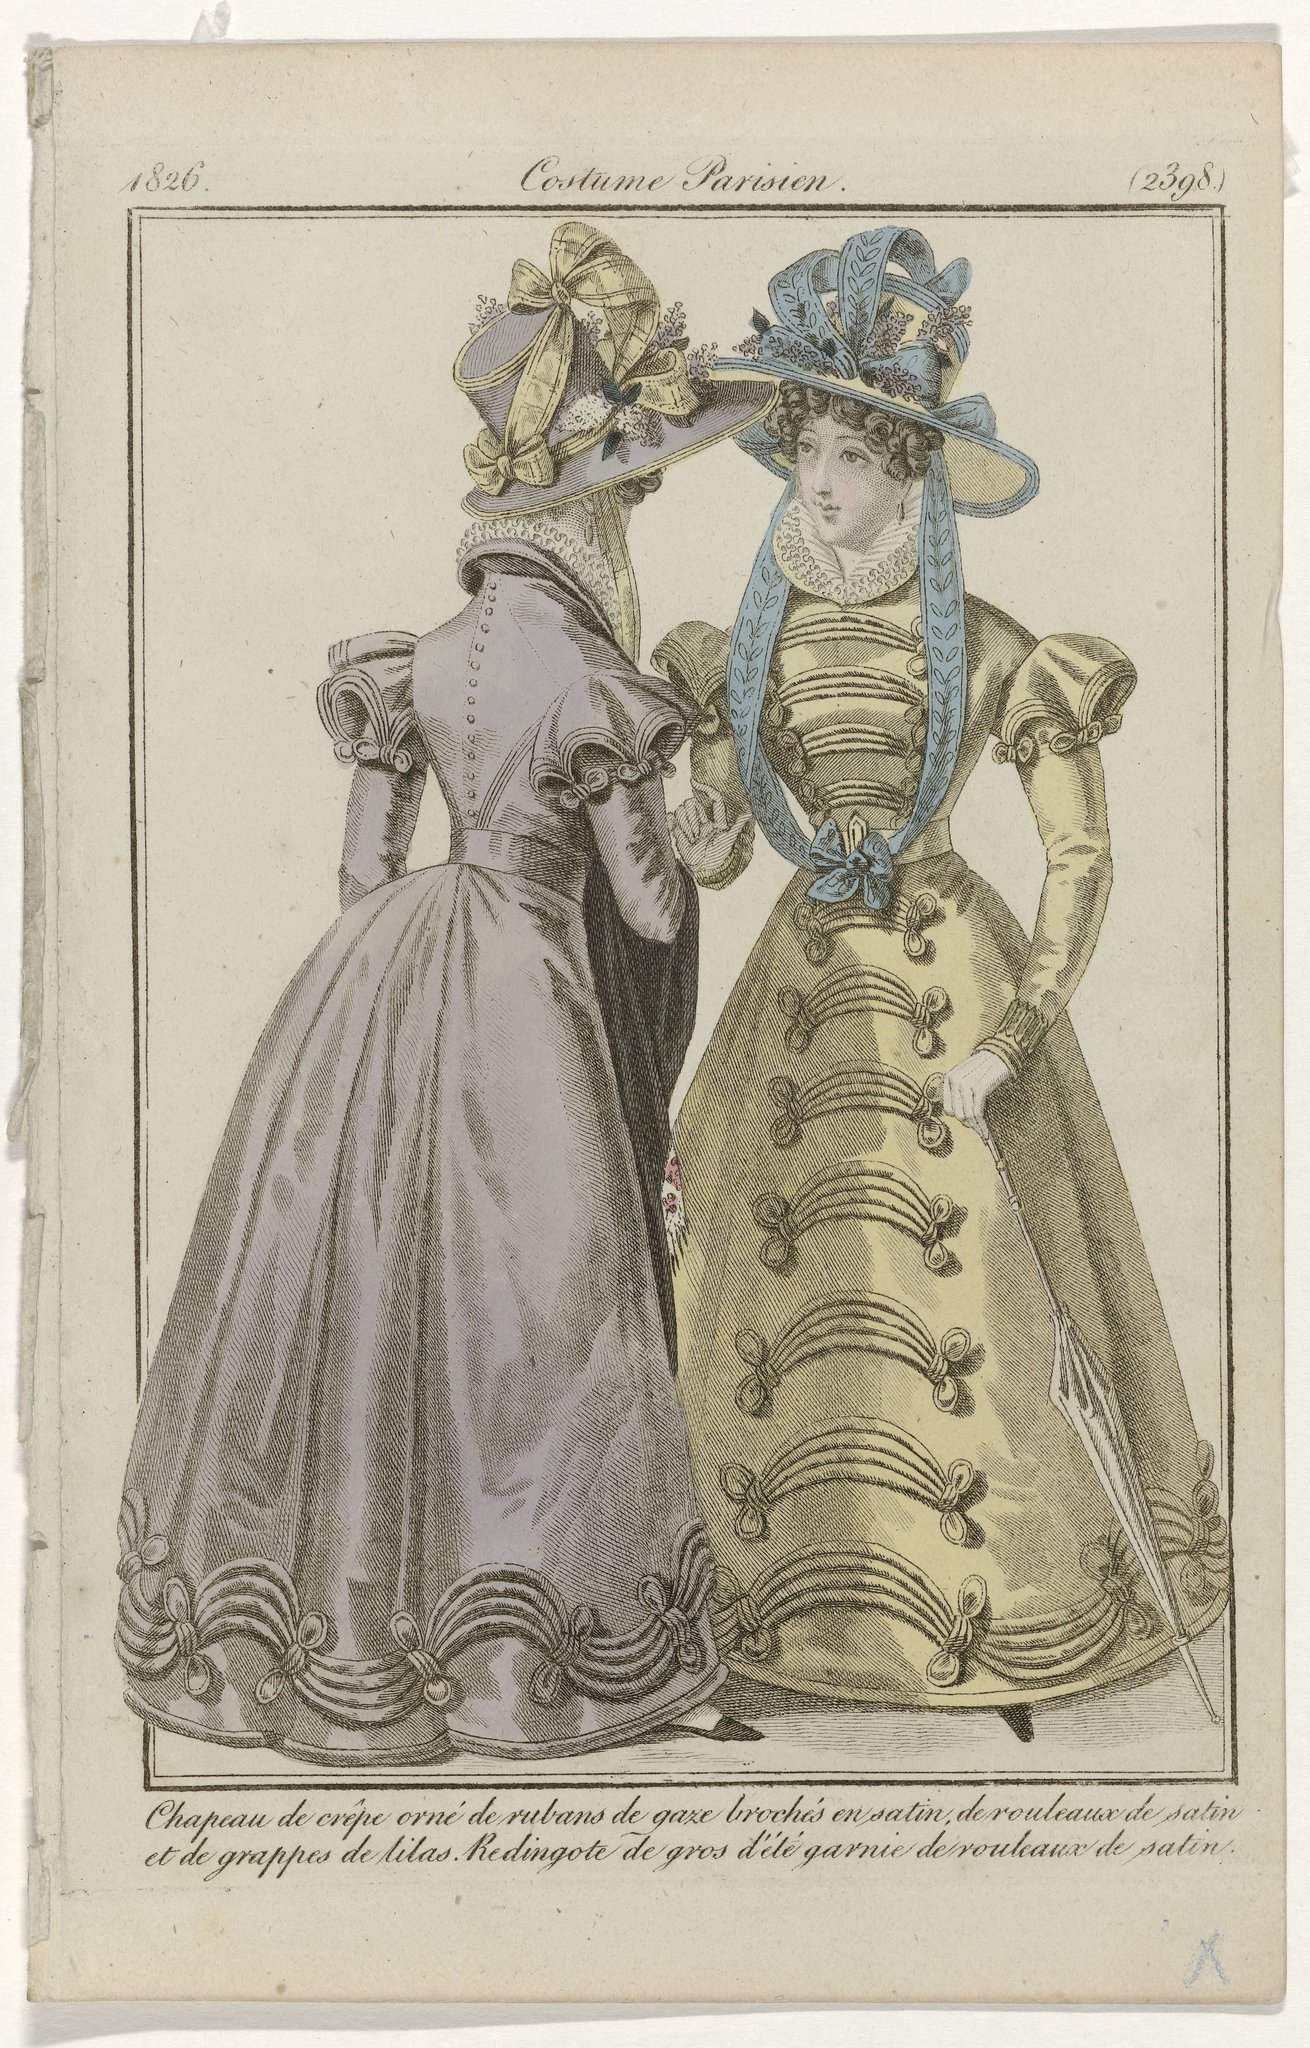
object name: fashion print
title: Journal des Dames et des Modes, Costume Parisien, 15 avril 1826, (2398): Chapeau de crêp (...)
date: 1826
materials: paper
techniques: engraving, hand coloring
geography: paris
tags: flowers, clothing for the upper part of the body (shawl) (+ women's clothes), border, ribbon, braid (+ women's clothes), dress, gown: redingote (+ women's clothes), fashion plates, head-gear: hat (+ women's clothes), parasol, sunshade (+ women's clothes)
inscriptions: title: ‘Costume Parisien.’, caption: ‘Chapeau de crêpe orné de rubans de gaze brochés en satin, de rouleaux de satin et de grappes de lilas. Redingote de gros d'été garnie de rouleaux de satin.’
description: Vrouw gekleed in een redingote van 'gros d'été' versierd met een 'rouleaux' van satijn. Op het hoofd een hoed van crêpe versierd met linten van 'gaze brochés en satin', 'rouleaux' van satijn en seringen. Verdere accessoires: oorbellen, handschoenen, armband, parasol. Figuur in eenzelfde redingote, op de rug gezien. De prent maakt deel uit van het modetijdschrift Journal des Dames et des Modes, uitgegeven door Pierre de la Mésangère, Parijs, 1797-1839.